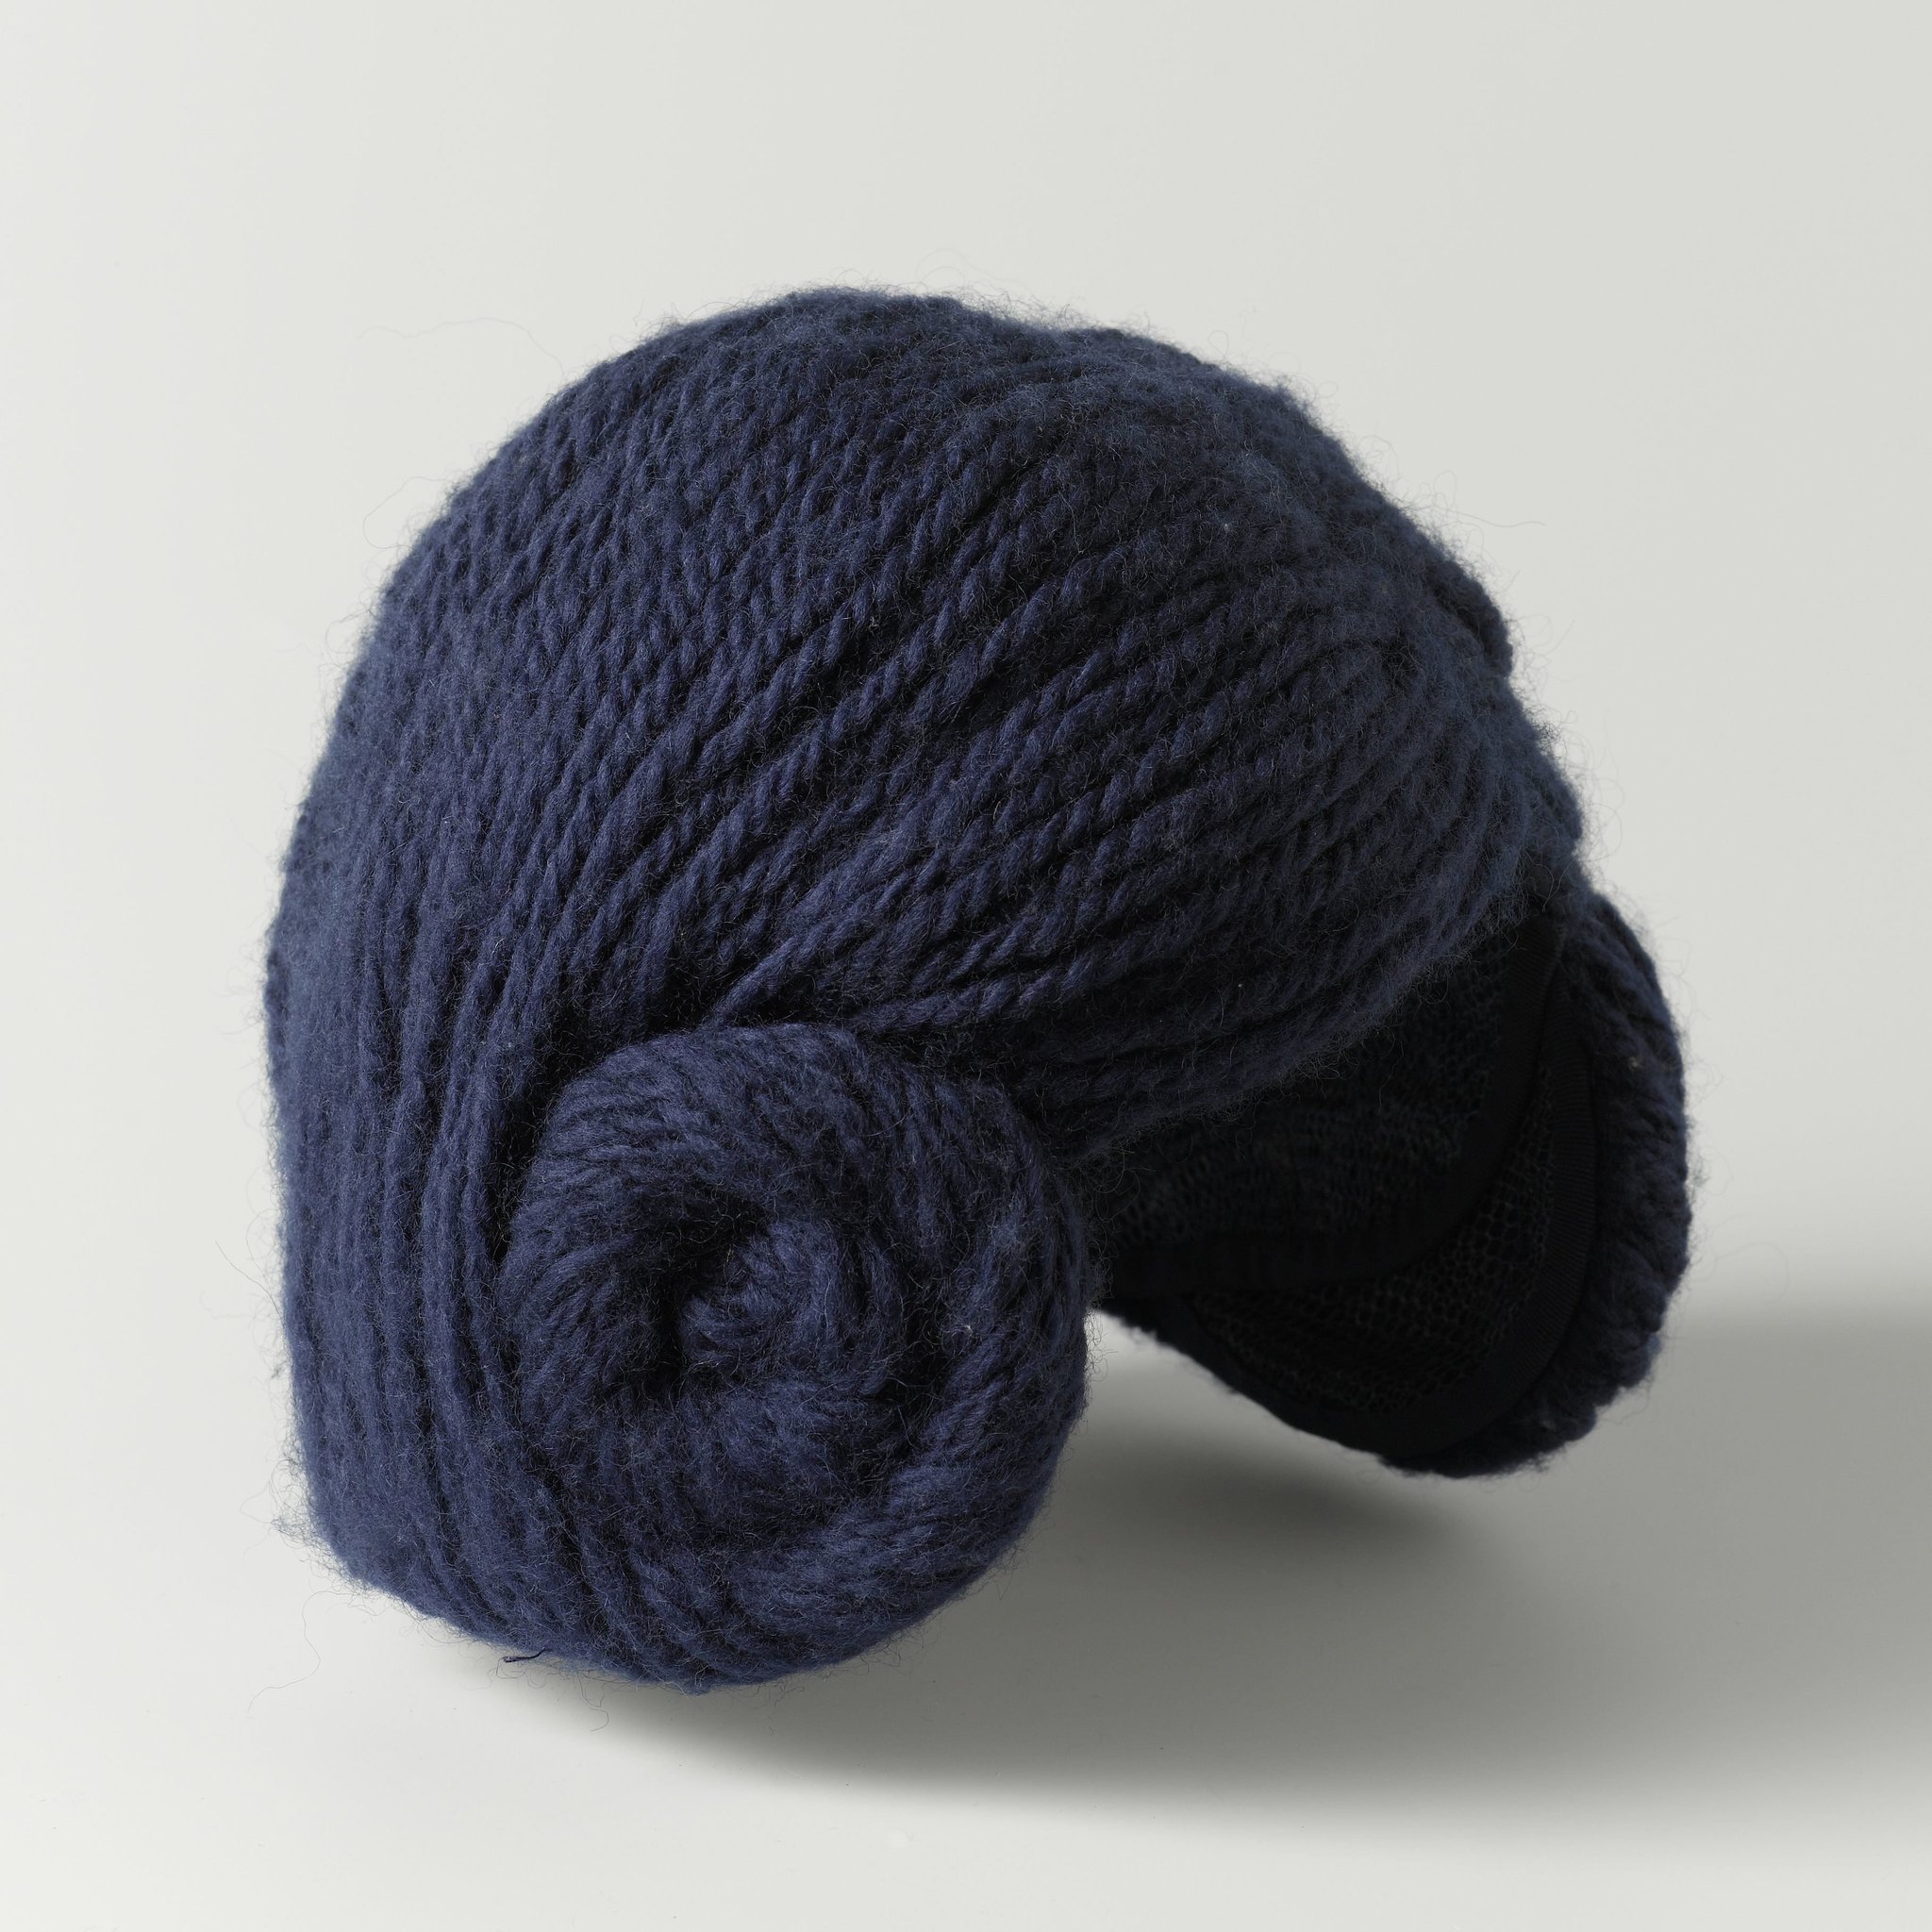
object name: cap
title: Muts van blauwe wol opgemaakt als een plat kapsel met scheiding links en wrongen rond de oren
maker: paulette modes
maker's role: hoedenmaakster, modiste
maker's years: 1900-1984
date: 1950-1960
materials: wool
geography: paris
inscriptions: mark: ‘PAULETTE’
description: Muts van blauwe wol opgemaakt als een plat kapsel met scheiding links en wrongen rond de oren, gevoerd met een dubbele laag blauwe tule raide.